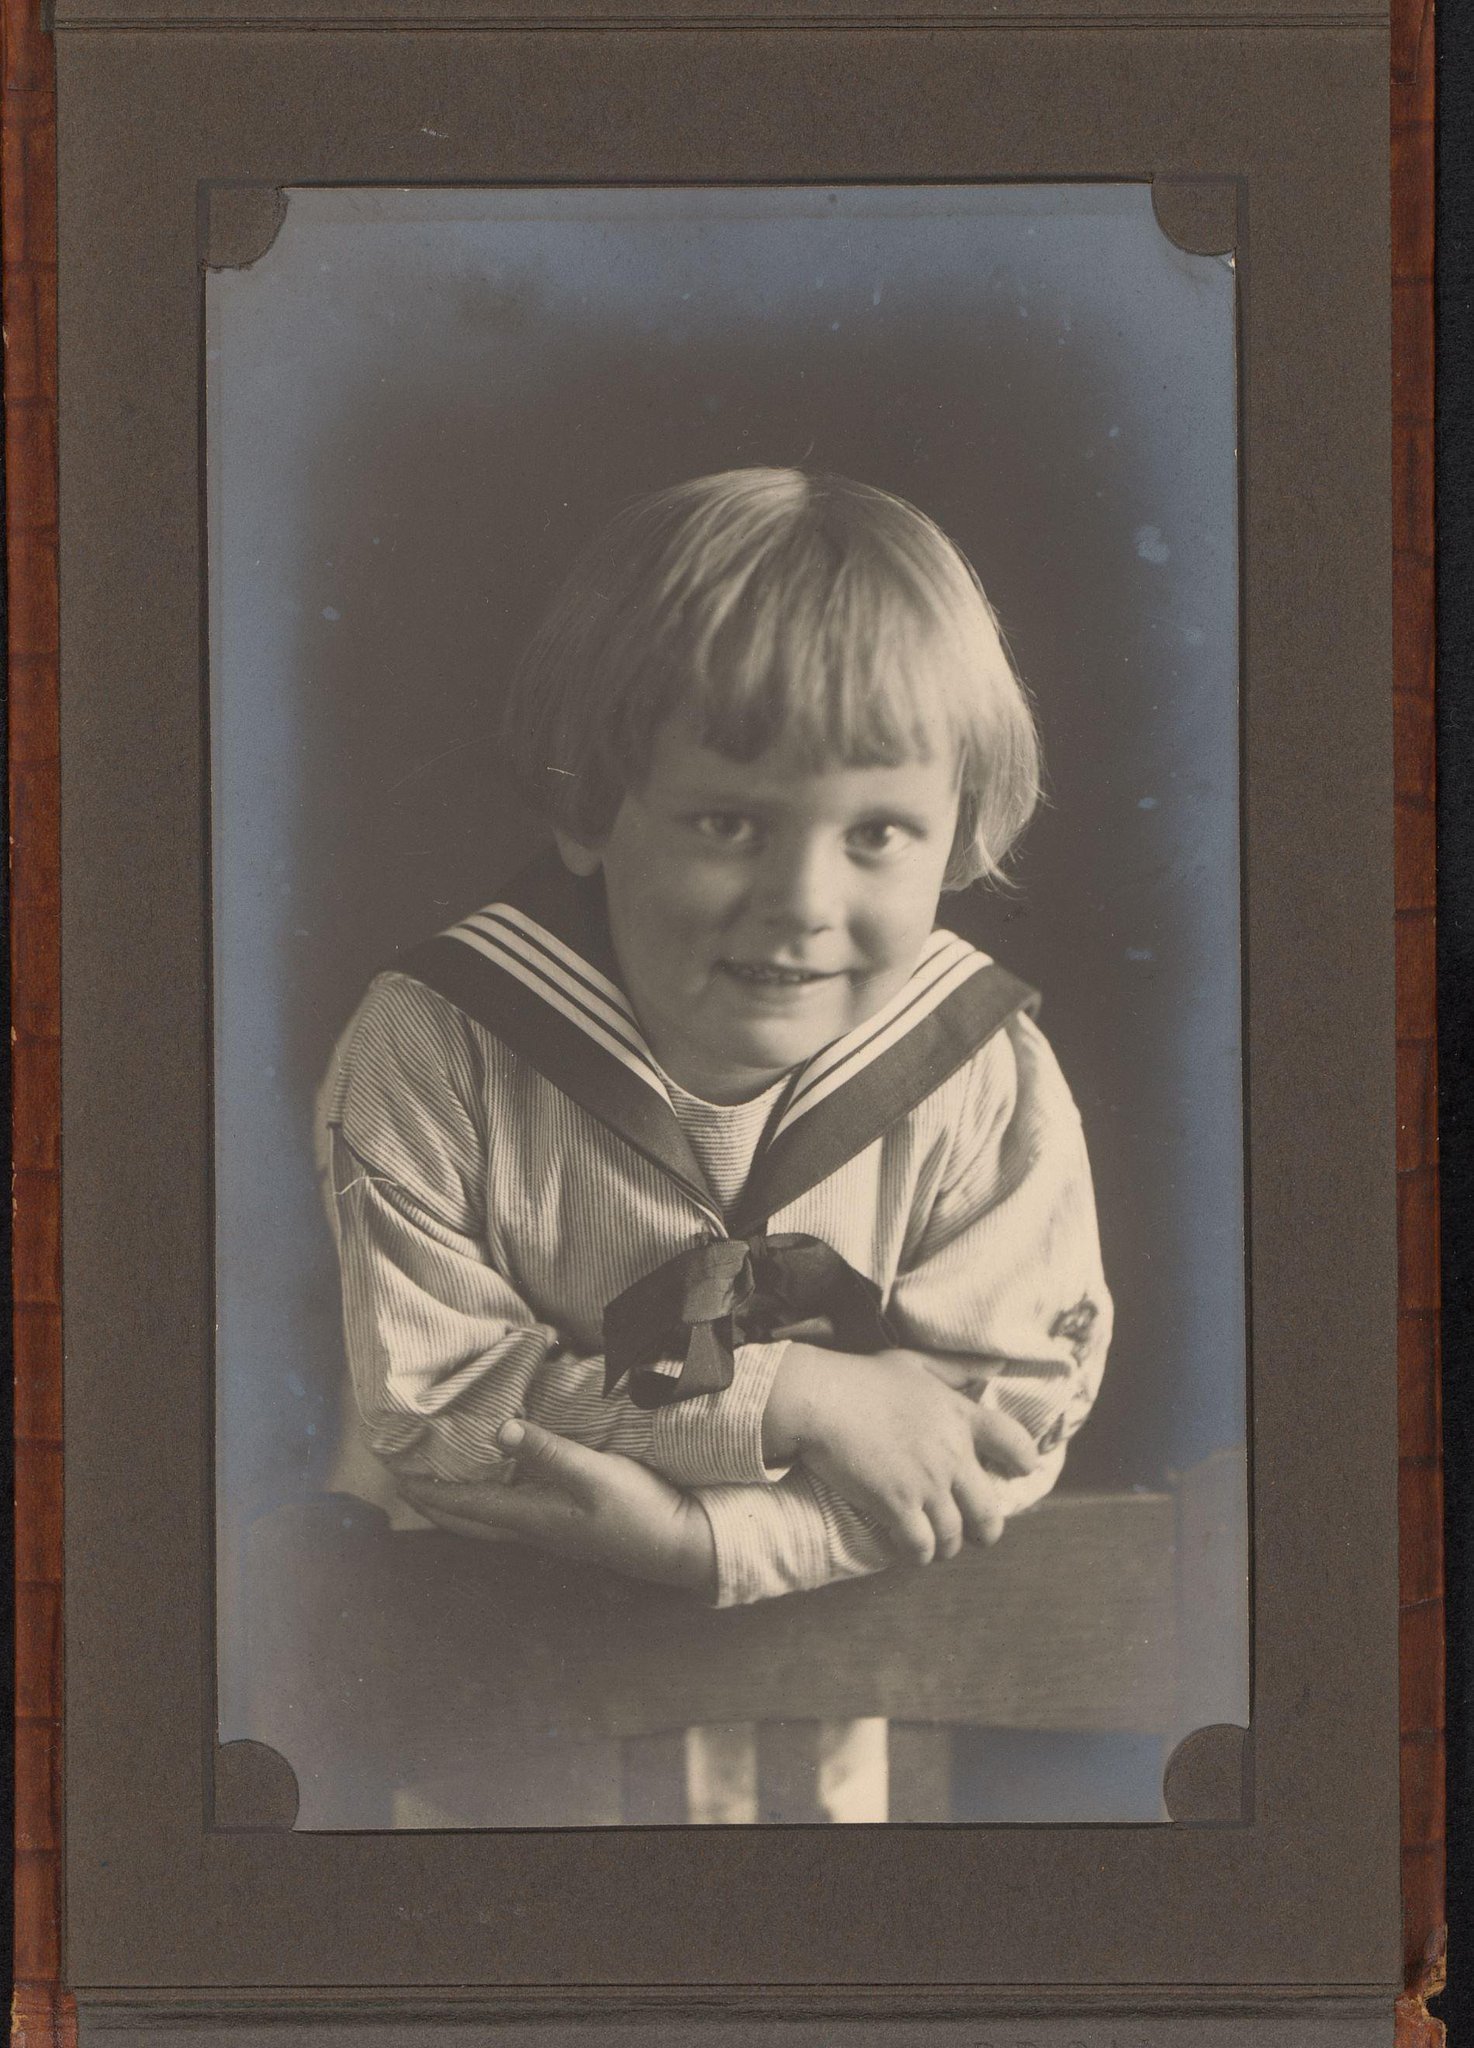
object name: album leaf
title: Portret van een kind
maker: Anonymous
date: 1930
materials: cardboard, photographic support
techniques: gelatin silver print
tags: child, historical persons